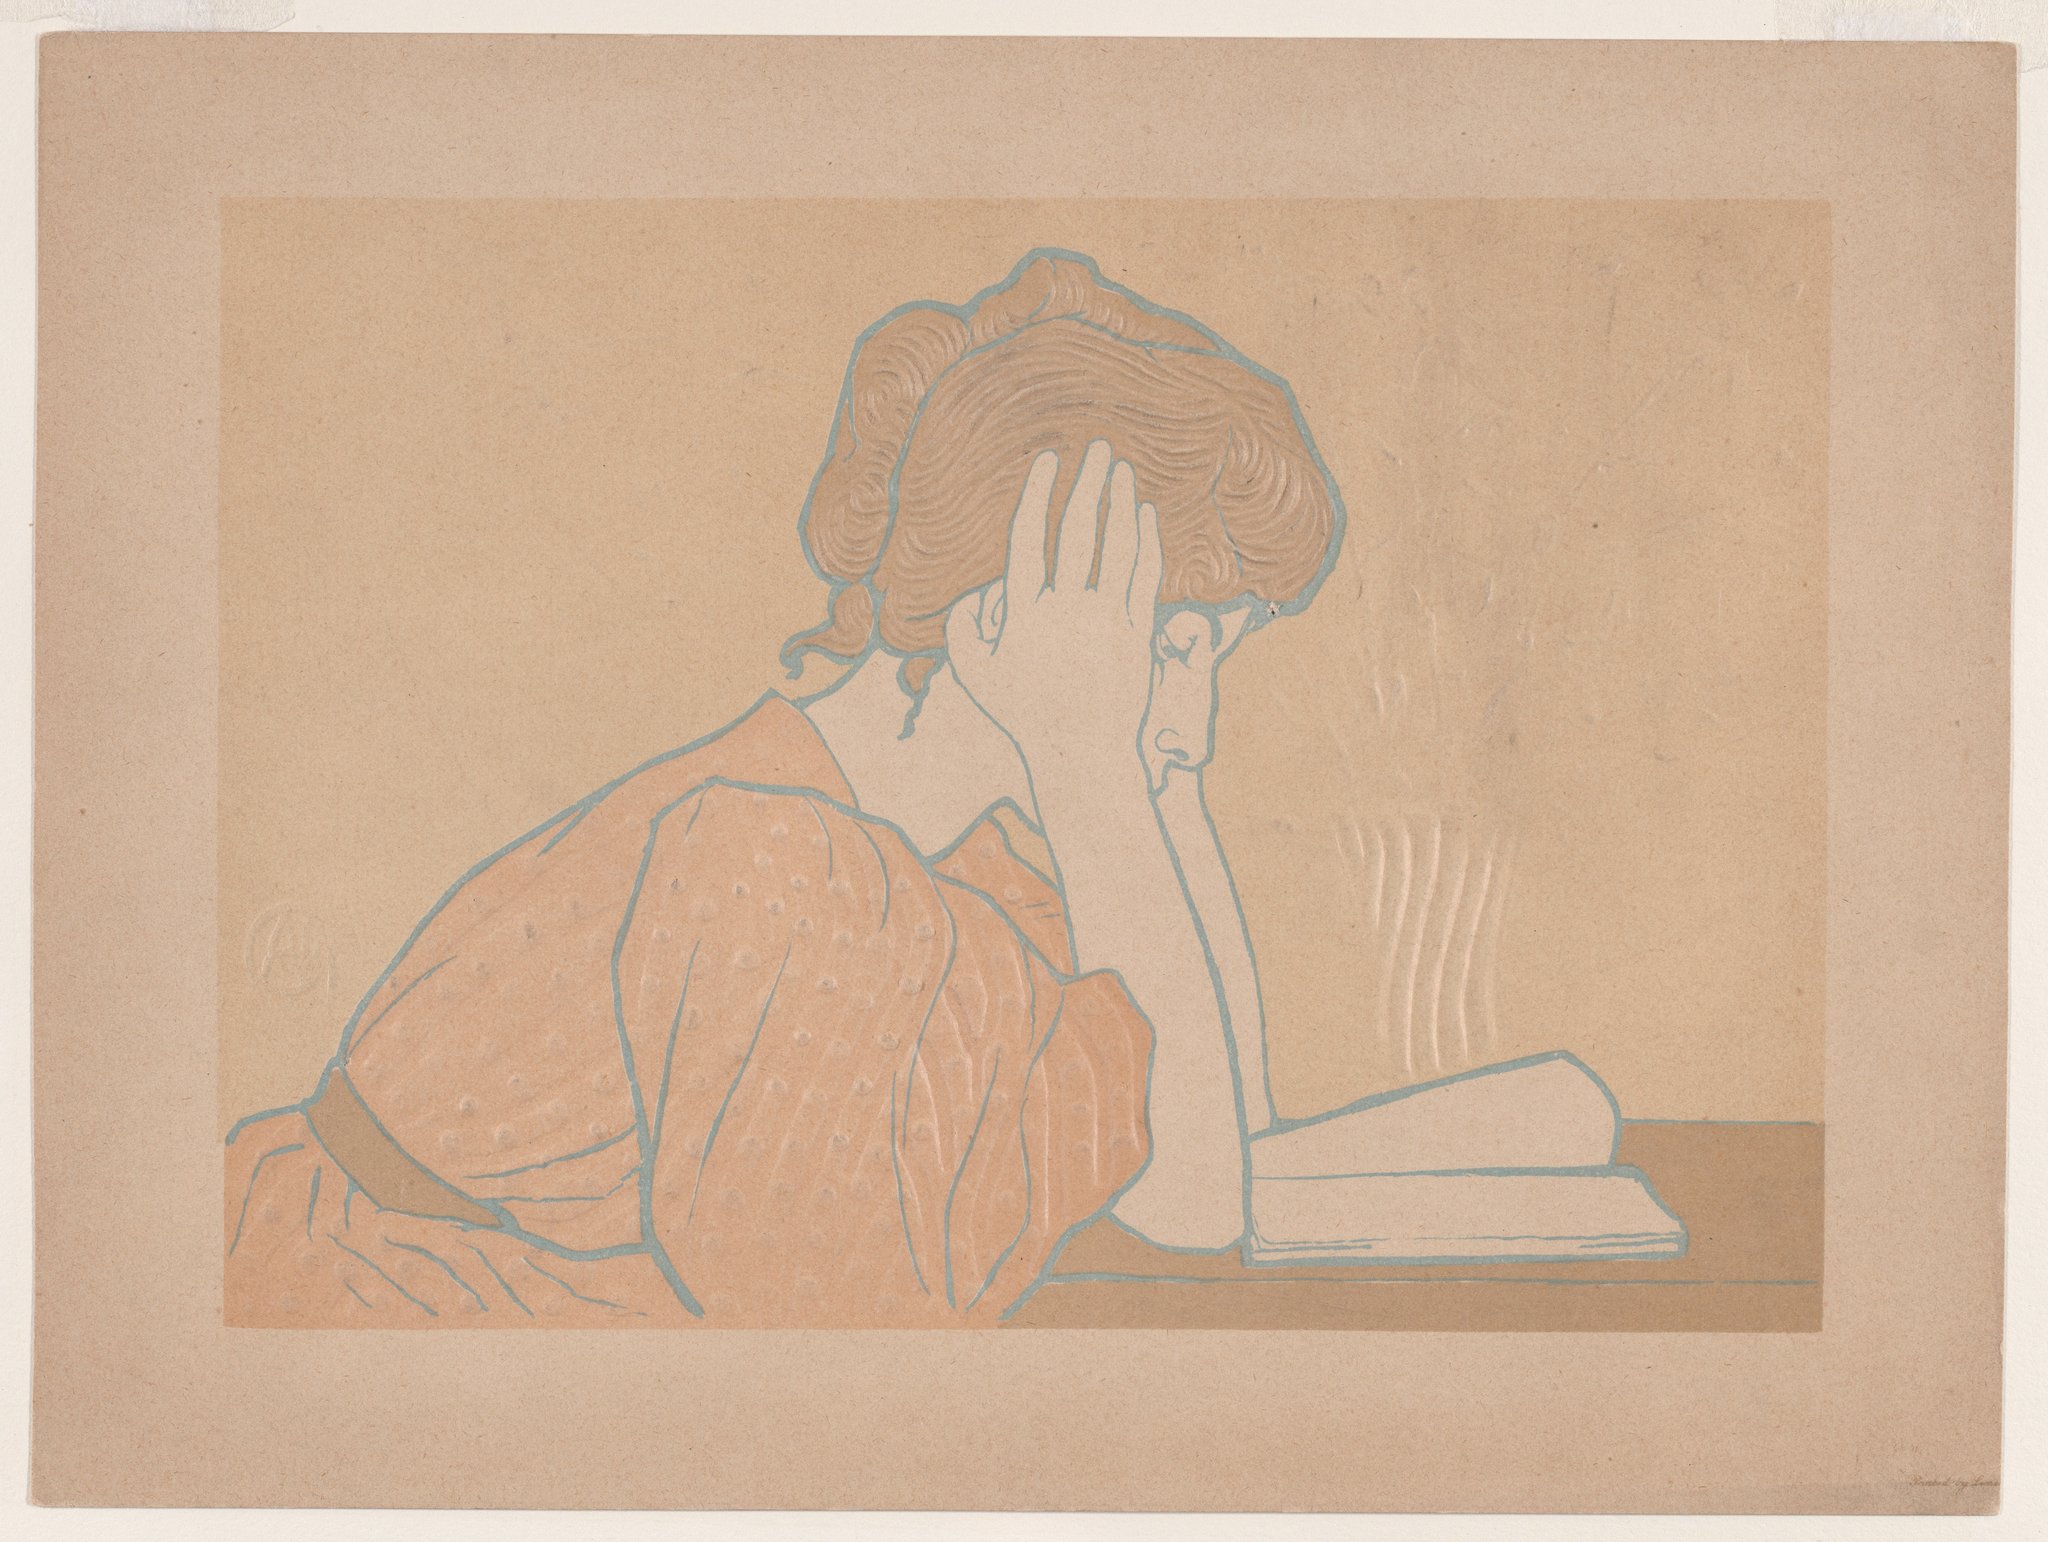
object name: print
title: Young Woman Reading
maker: alexandre-louis-marie charpentier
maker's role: artist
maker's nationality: french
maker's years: 1856-1909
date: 1896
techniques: embossing, lithograph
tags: women,reading